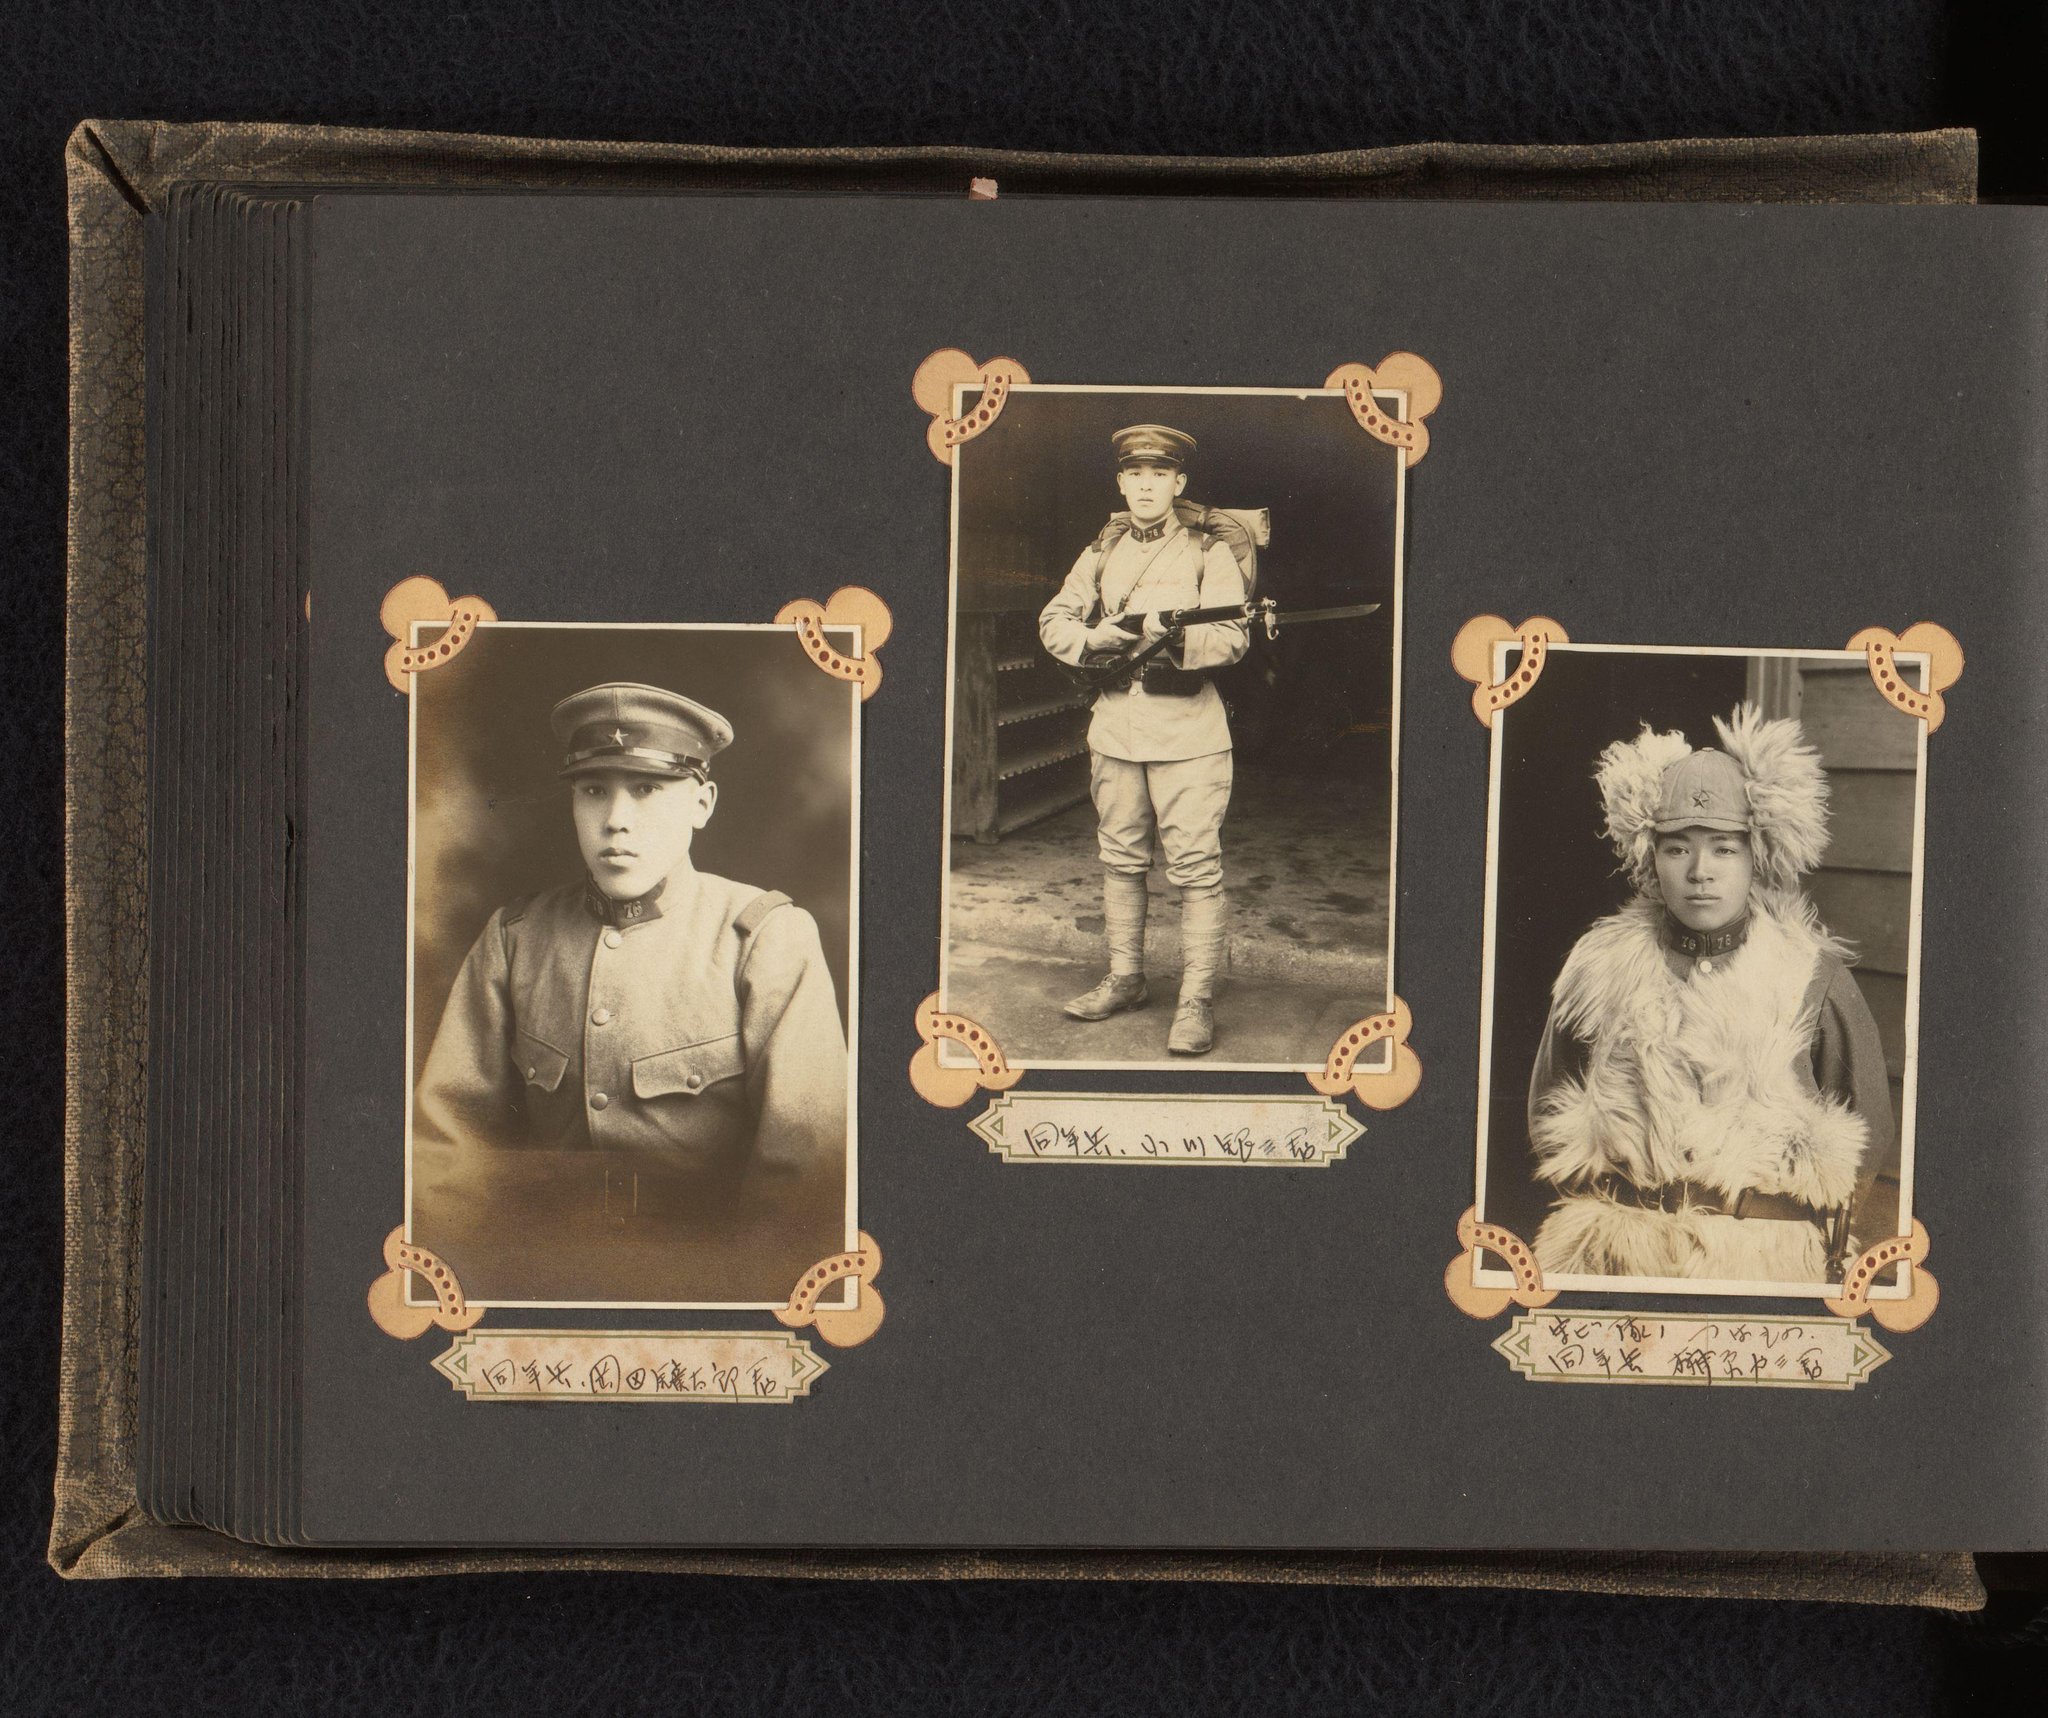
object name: photograph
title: Drie portretten van onbekende Japanse soldaten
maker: Anonymous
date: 1930-1940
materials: paper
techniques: gelatin silver print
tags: anonymous historical person portrayed, the soldier; the soldier's life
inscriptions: inscription: ‘[...]’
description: Deze foto's zijn onderdeel van een album.